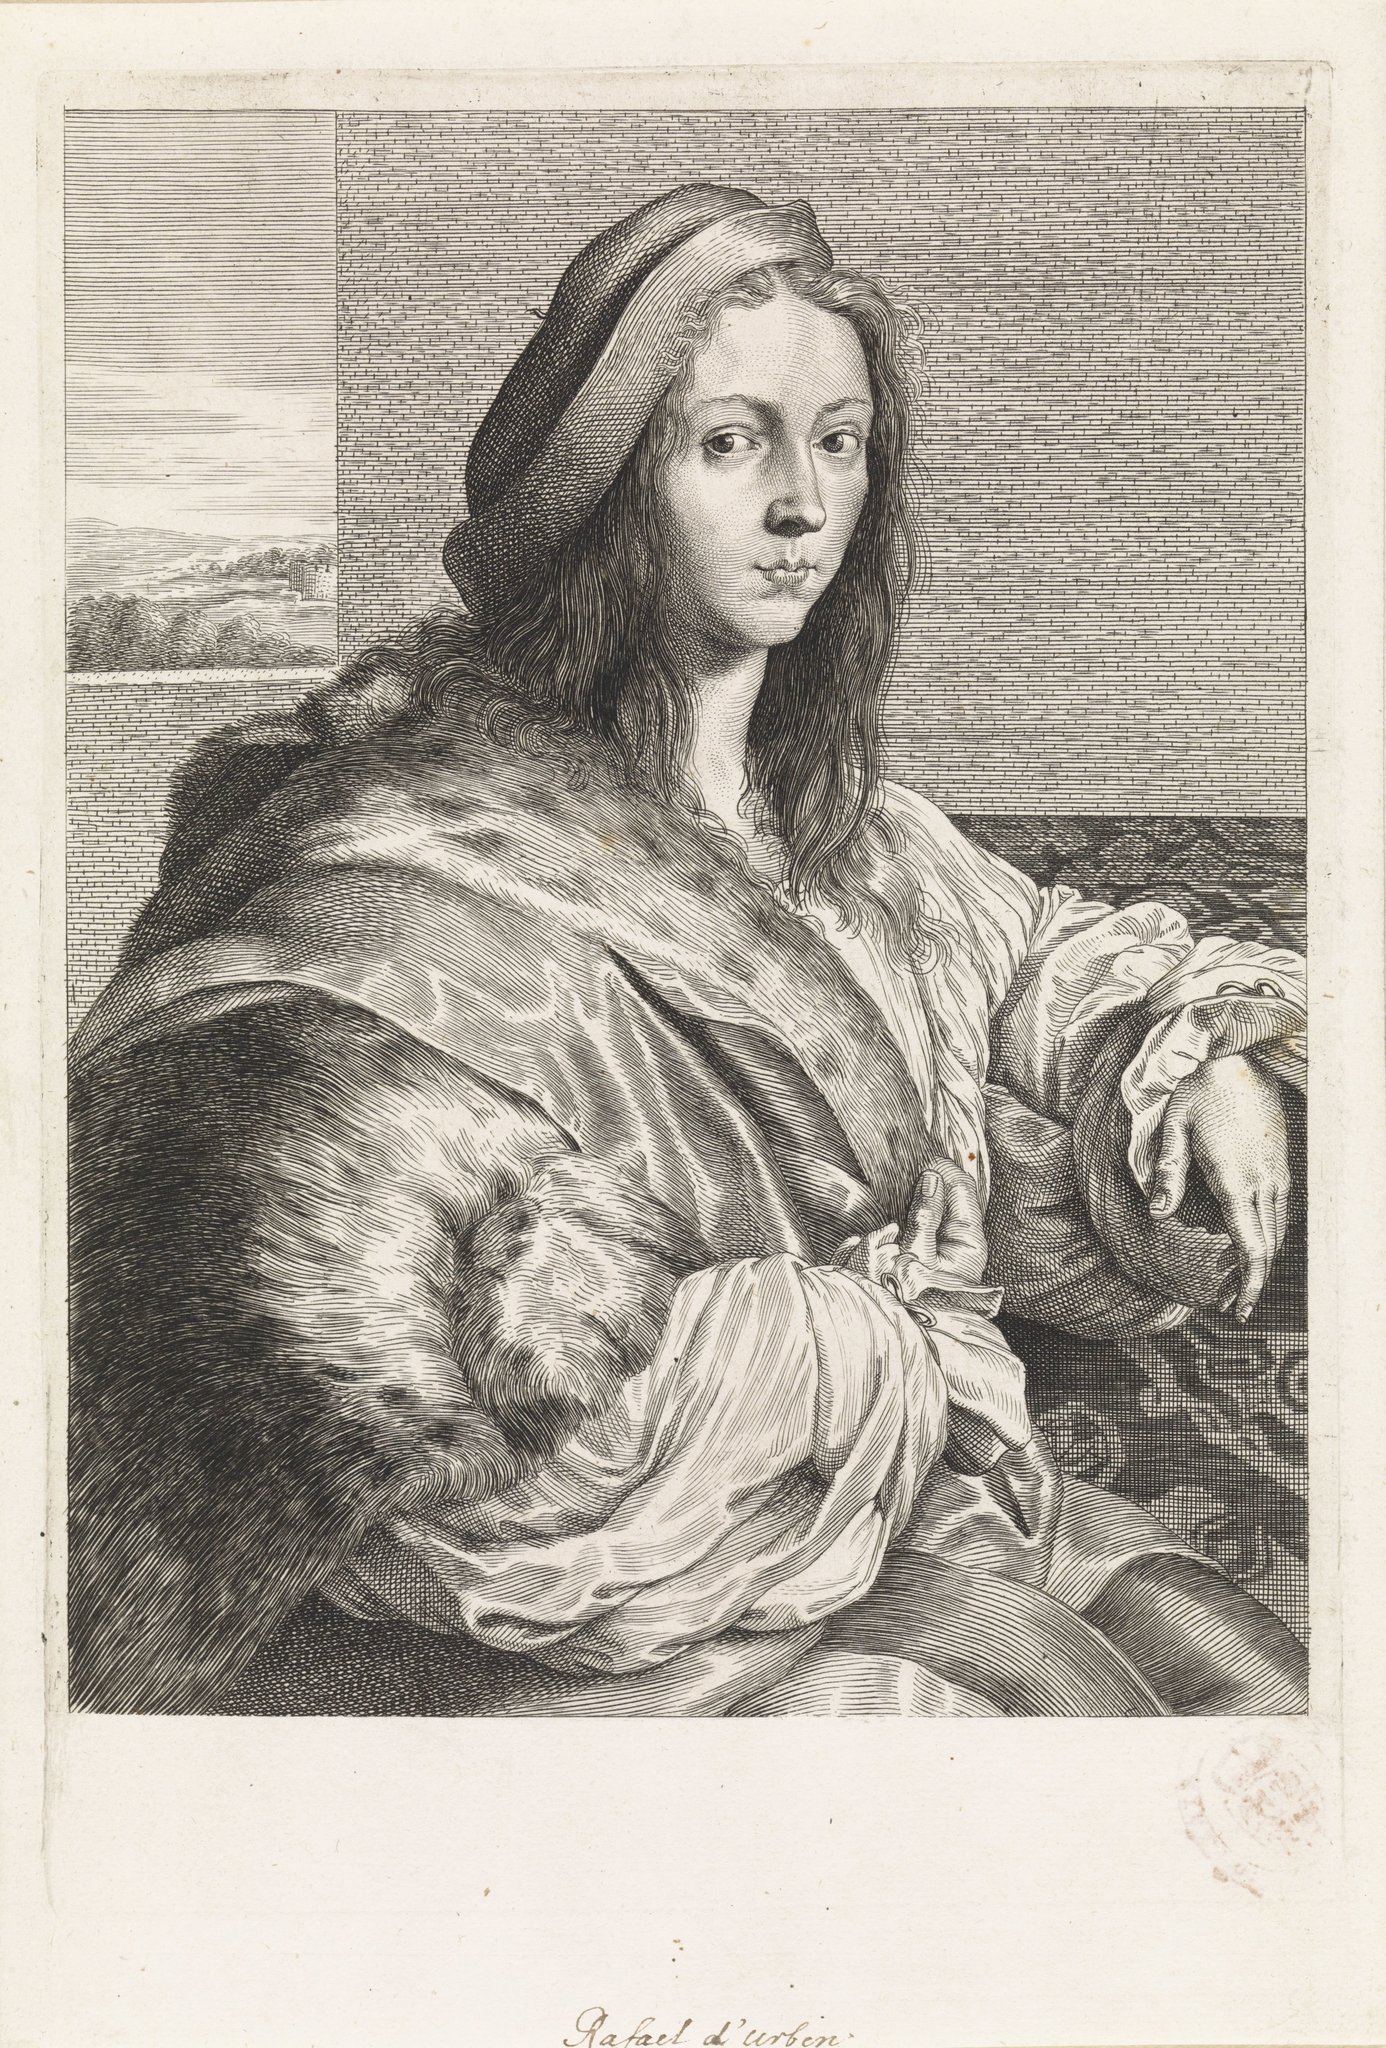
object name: print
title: Portret van de schilder Raphael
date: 1613-1658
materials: paper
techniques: engraving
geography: antwerp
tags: rome, painter, rafaël, portrait, self-portrait of painter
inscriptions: name: ‘Rafael d'Urben’, collector's mark: Lugt 240